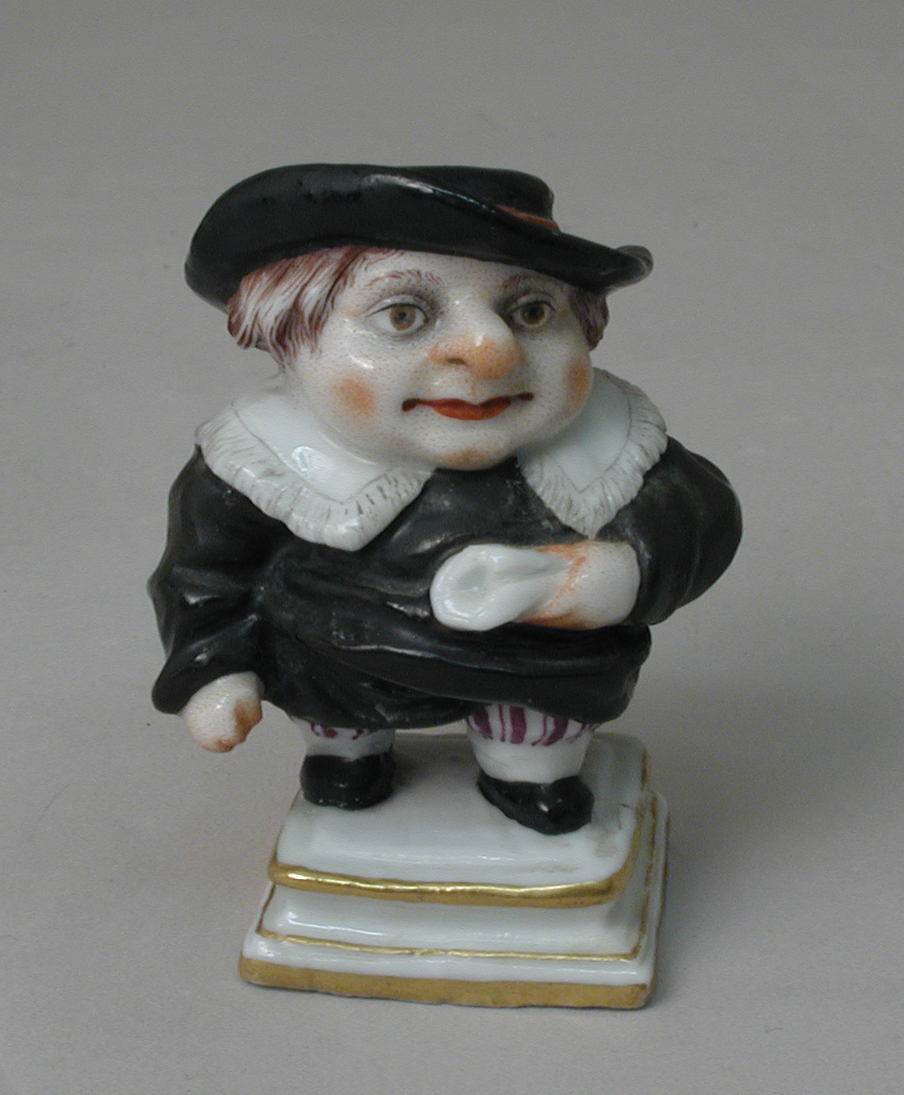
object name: figure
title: Dwarf (one of three)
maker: doccia porcelain manufactory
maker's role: manufactory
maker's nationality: italian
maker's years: 1737-1896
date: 1760-1770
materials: soft paste porcelain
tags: human figures